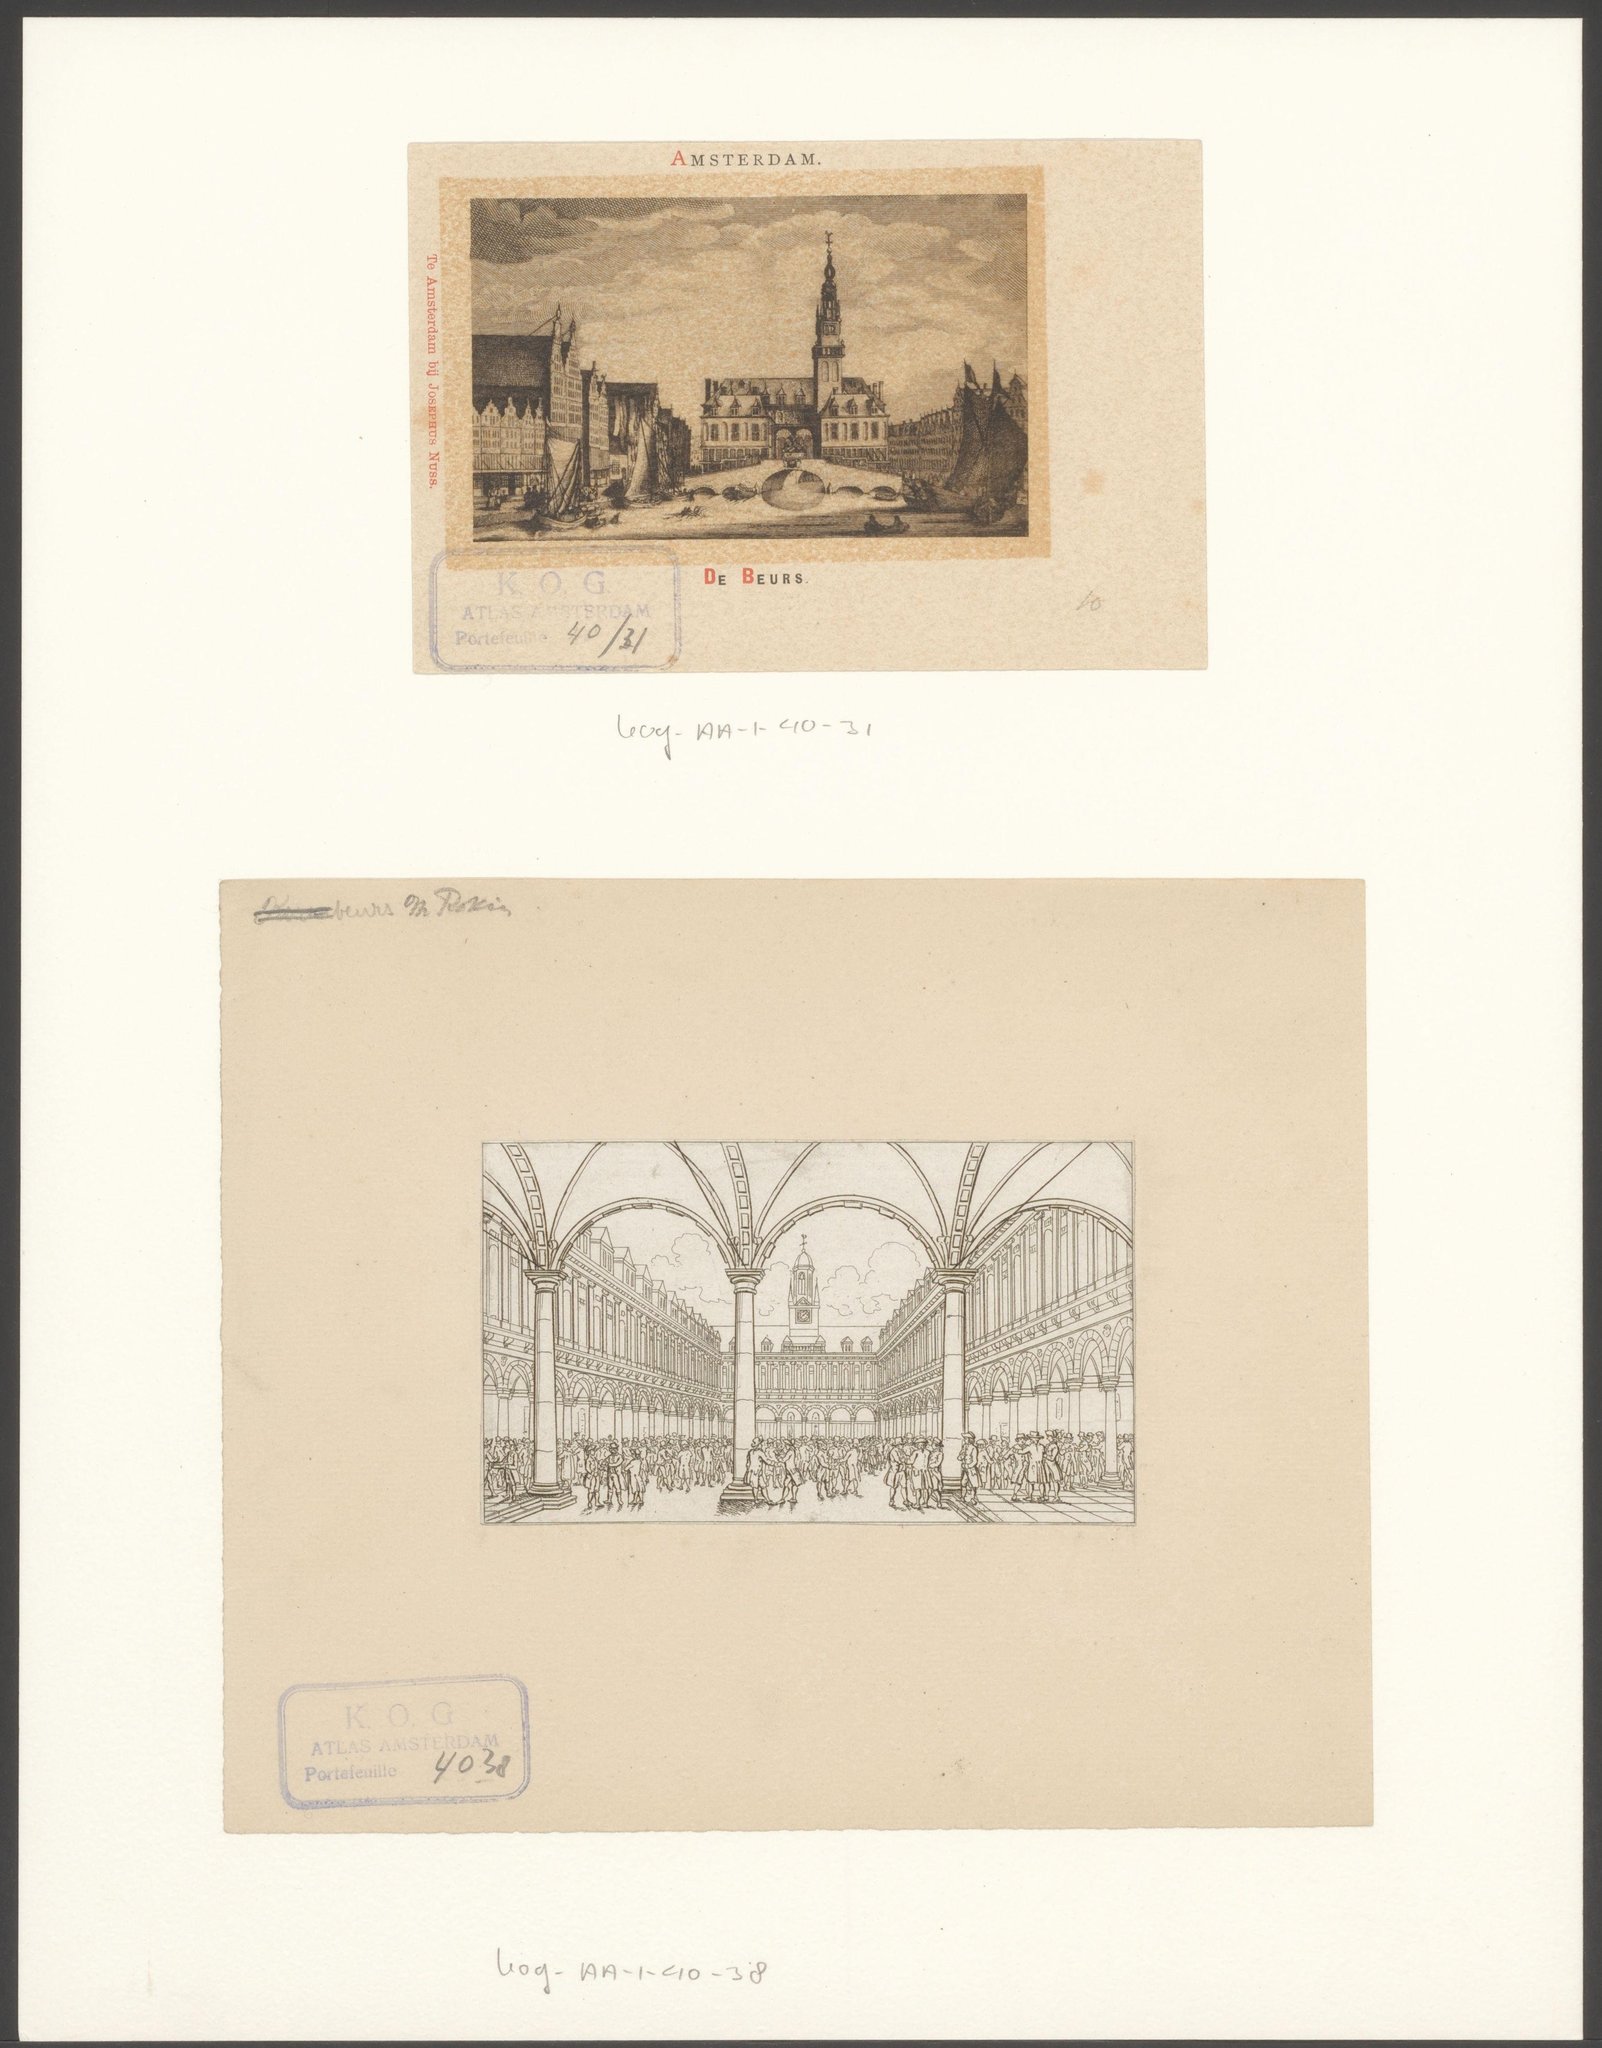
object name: ansichtkaart, prentbriefkaart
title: Gezicht op de Beurs van Hendrik de Keyser te Amsterdam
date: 1899-1903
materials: paper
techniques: photograph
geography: amsterdam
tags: bridge in city across river, canal, etc. (+ city(-scape) with figures, staffage), sailing-ship, sailing-boat, stock exchange, stock-market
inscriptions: collector's mark: Lugt 1641b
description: Onderwerpsrubriek binnen de Atlas Amsterdam: Handel en Zeevaart: Beurs op het Rokin.